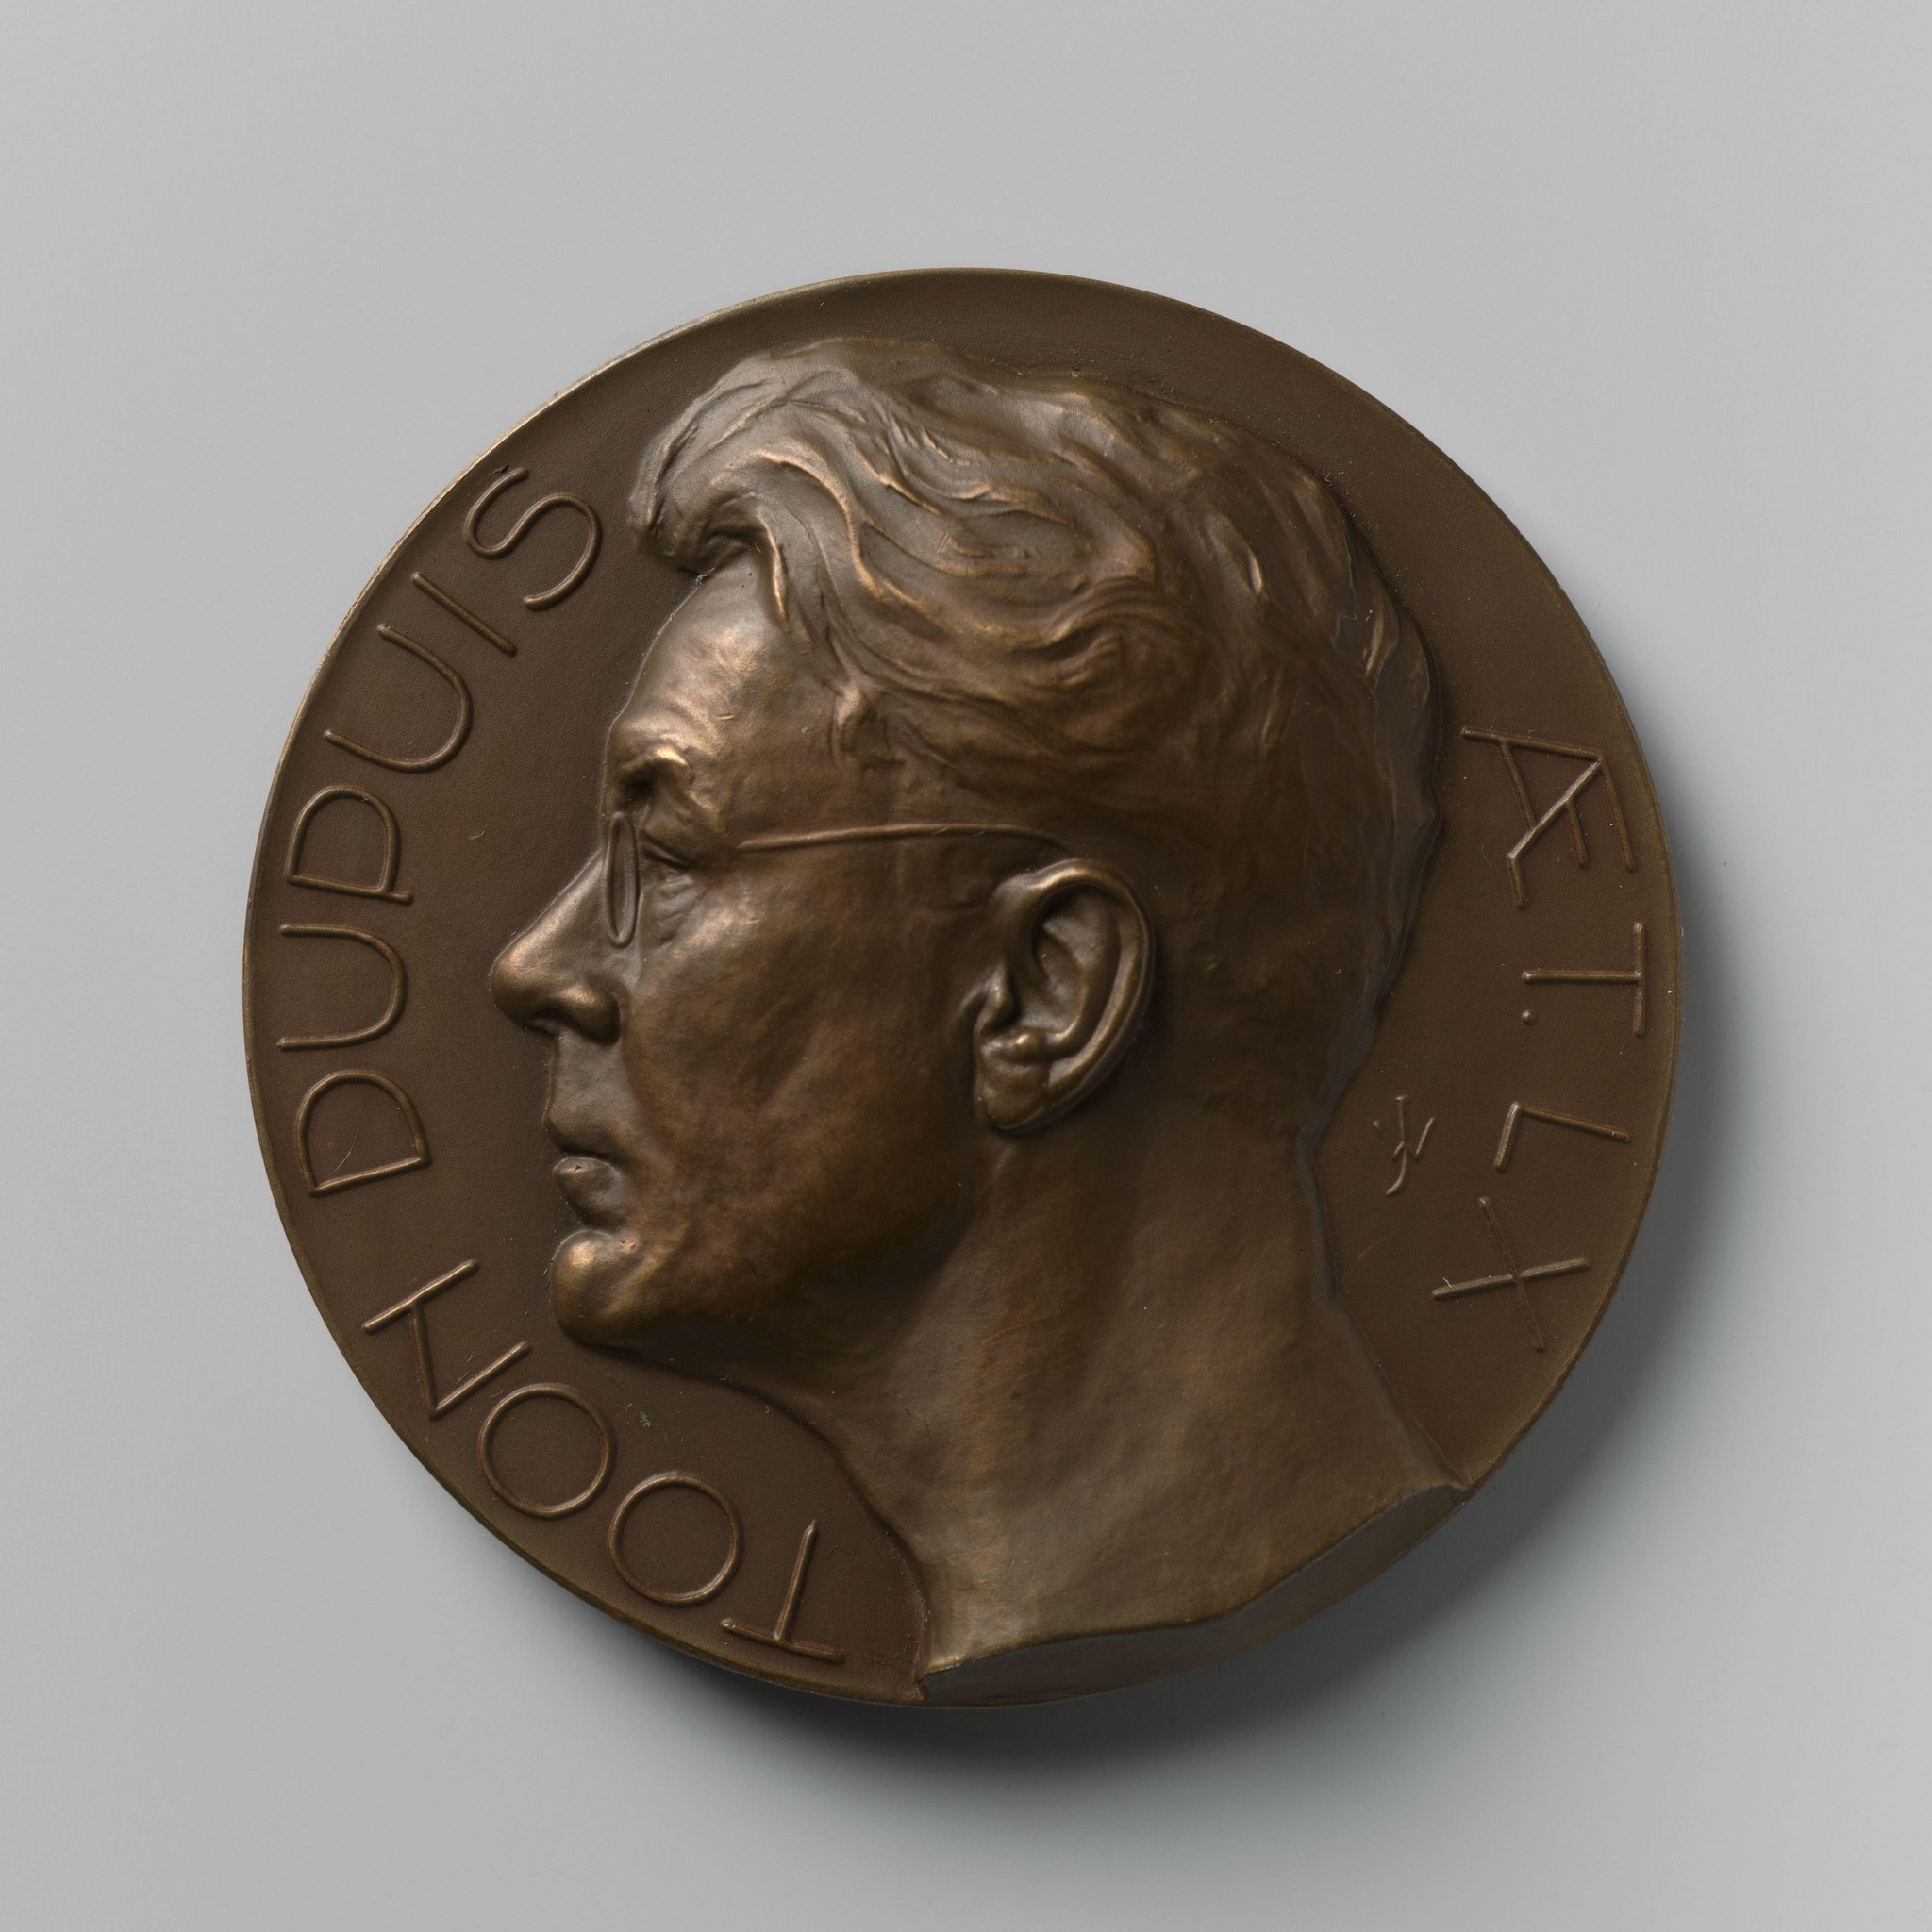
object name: history medal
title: Overlijden van Toon Dupuis (Vereniging voor Penningkunst 1936, tweede penning)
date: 1937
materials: bronze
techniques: striking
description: Bronzen penning, op de voorzijde het portret van Dupuis naar links met omschrift, op de keerzijde twee handen met hamer en beitel, met twee regels tekst.